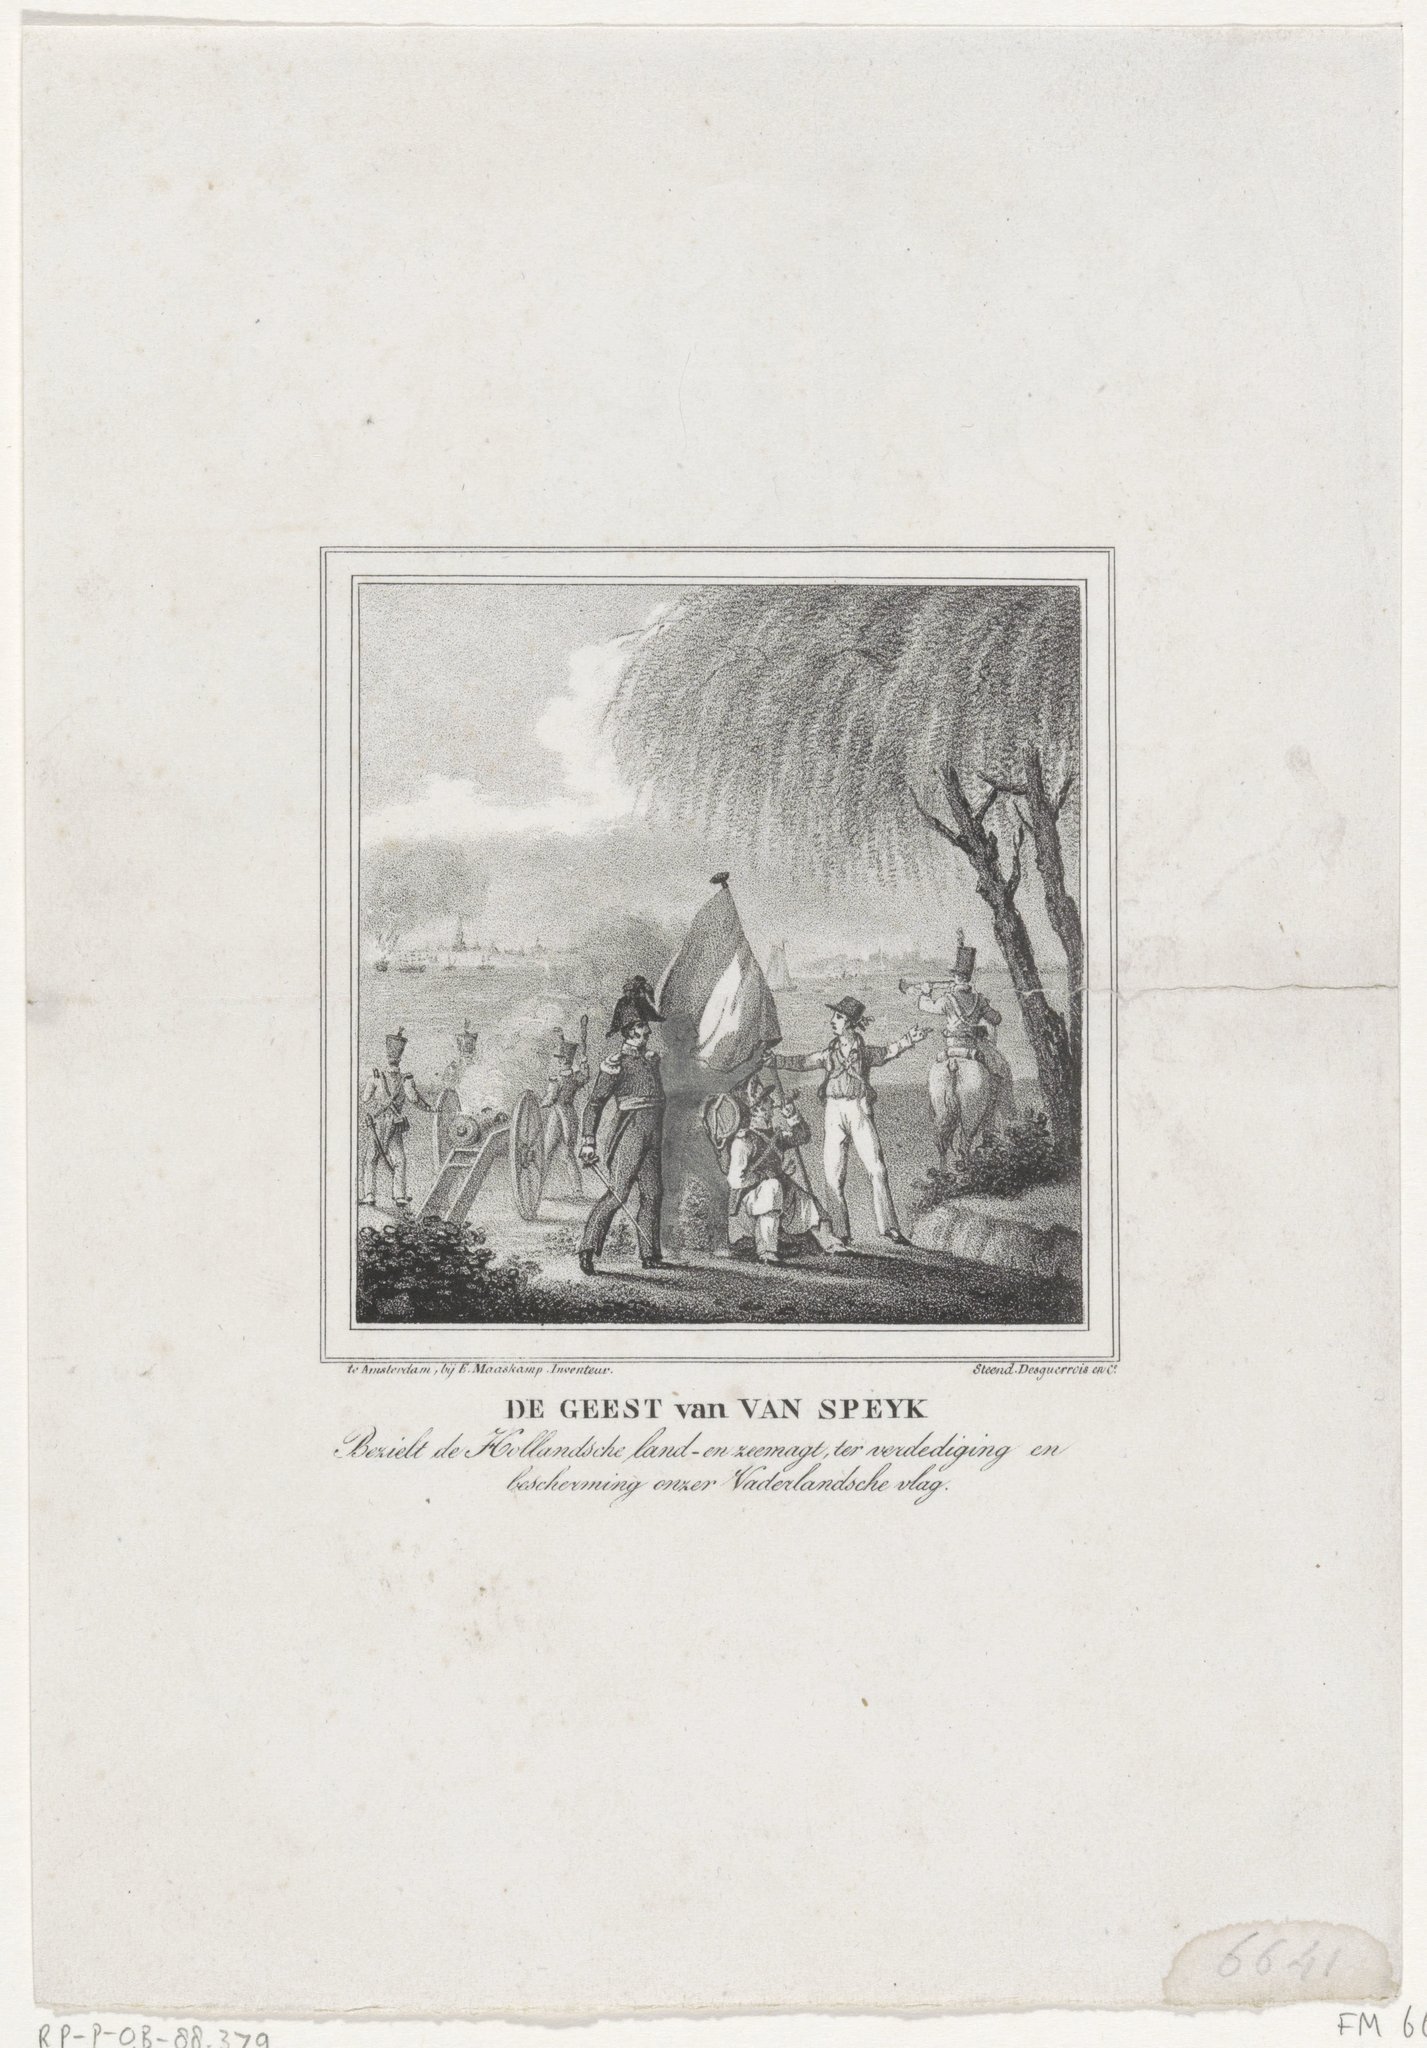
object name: print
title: De Geest van Van Speyk Bezielt de Hollandsche land- en zeemagt ter verdediging en bescherming onzer Nederlandsche vlag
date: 1831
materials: paper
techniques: lithograph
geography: netherlands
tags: antwerp, jan van speyk, battle, fighting in general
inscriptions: collector's mark: Lugt 2228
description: Verschillende militairen in een landschap. In de ruimte tussen de figuren is de verstopte gestalte van Jan van Speyk te ontwaren. In de verte het in de lucht springen van de kanonneerboot van Jan van Speyk op de Schelde voor Antwerpen op 5 februari 1831.